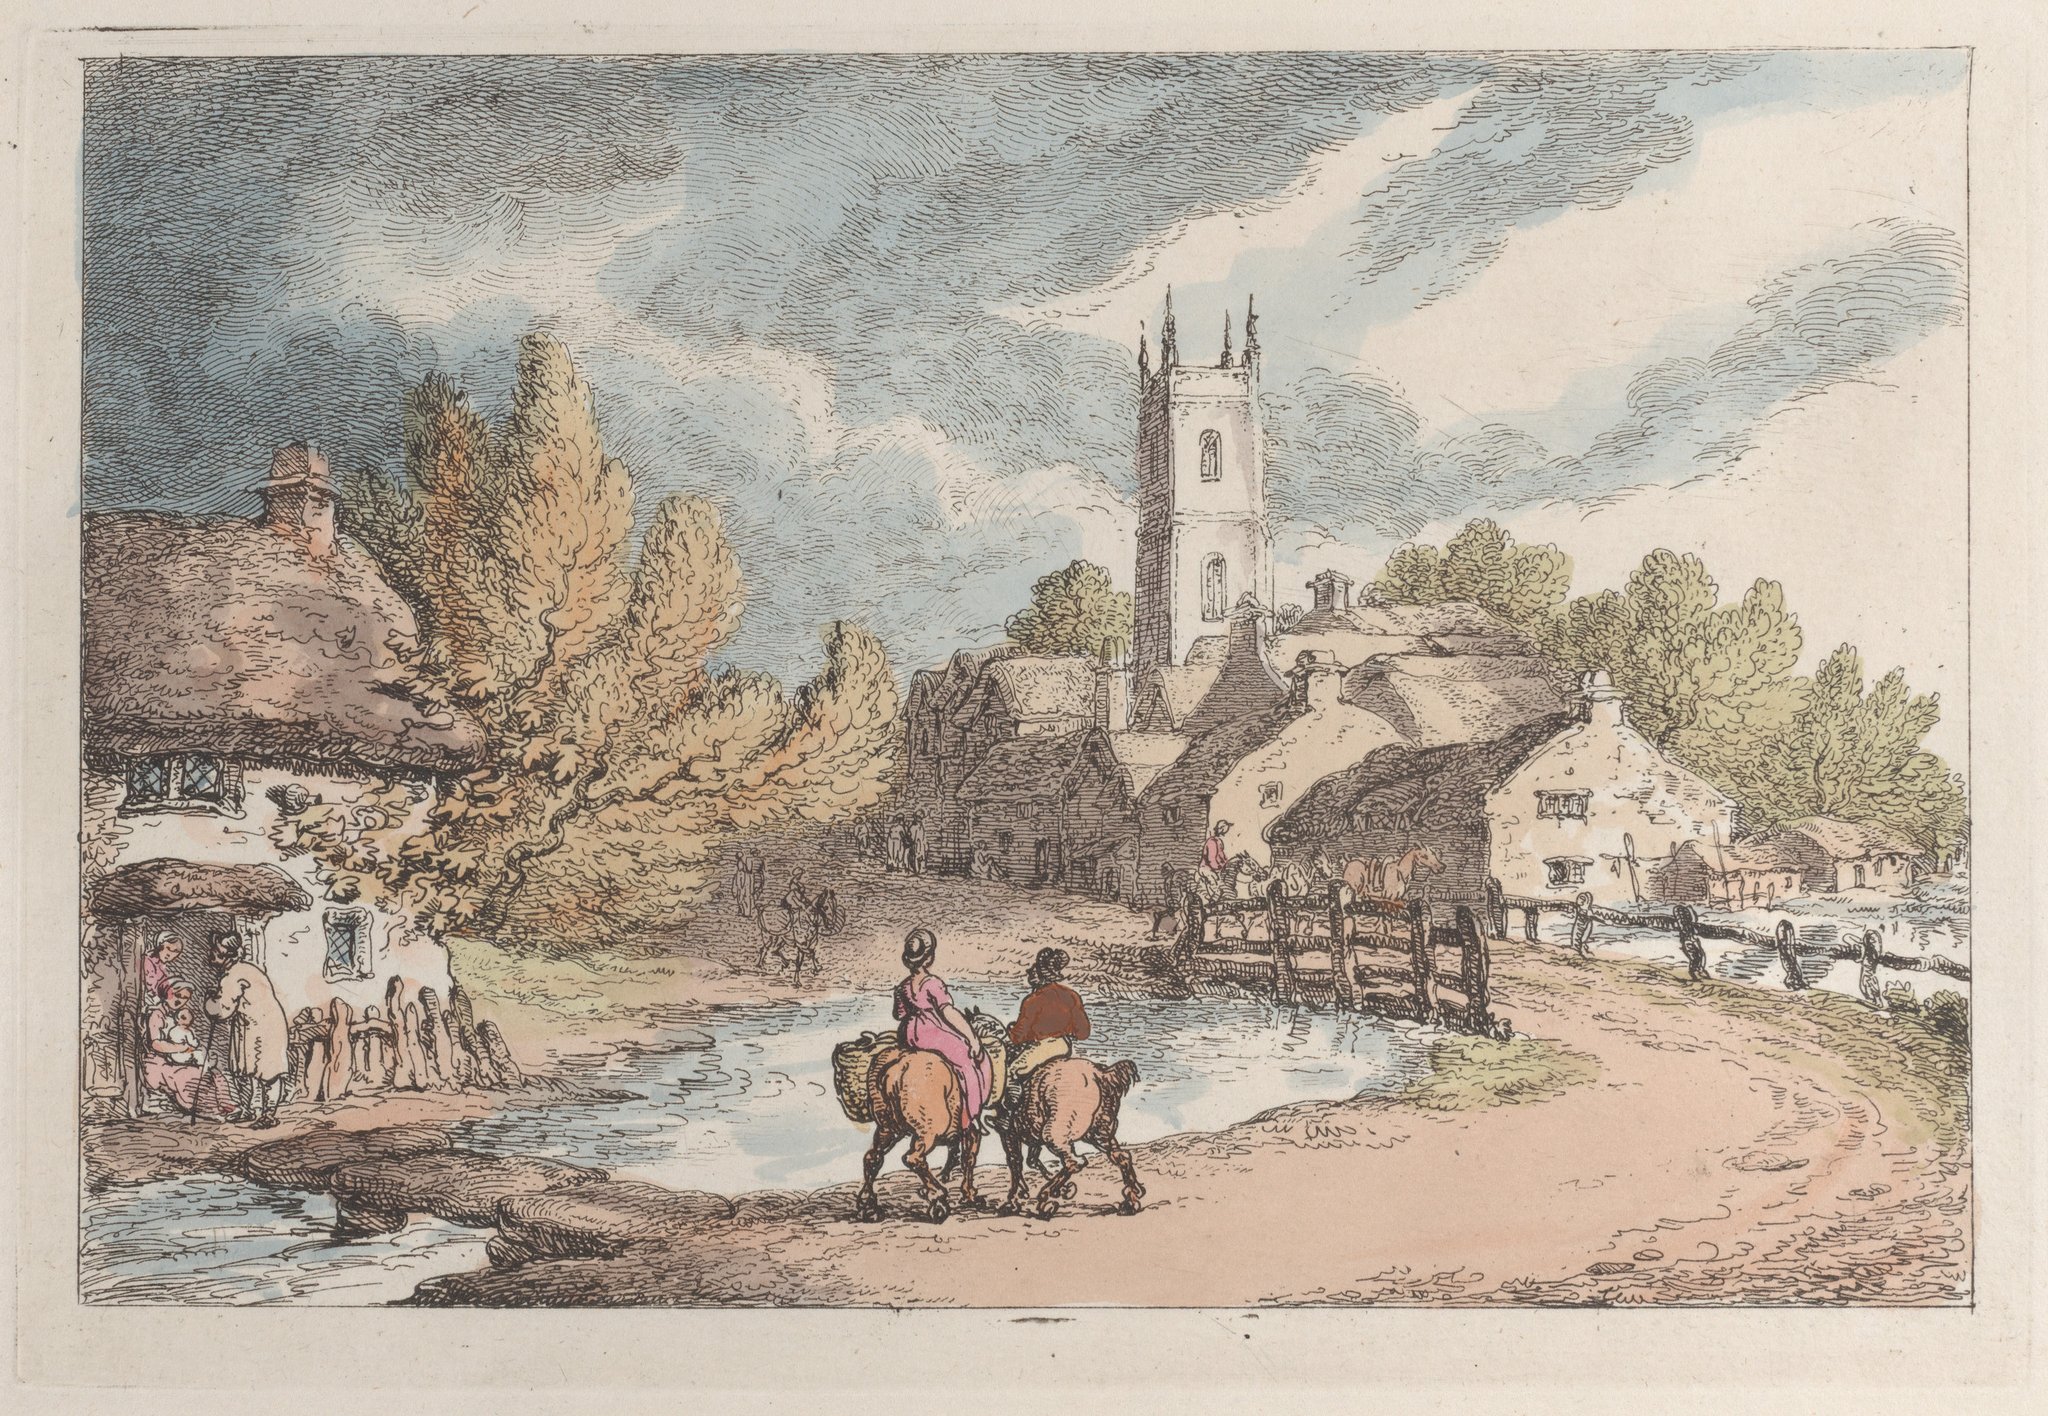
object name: print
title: Near Helston, Cornwall, from "Views in Cornwall"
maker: thomas rowlandson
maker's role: artist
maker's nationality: british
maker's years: 1757-1827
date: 1812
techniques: etching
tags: villages